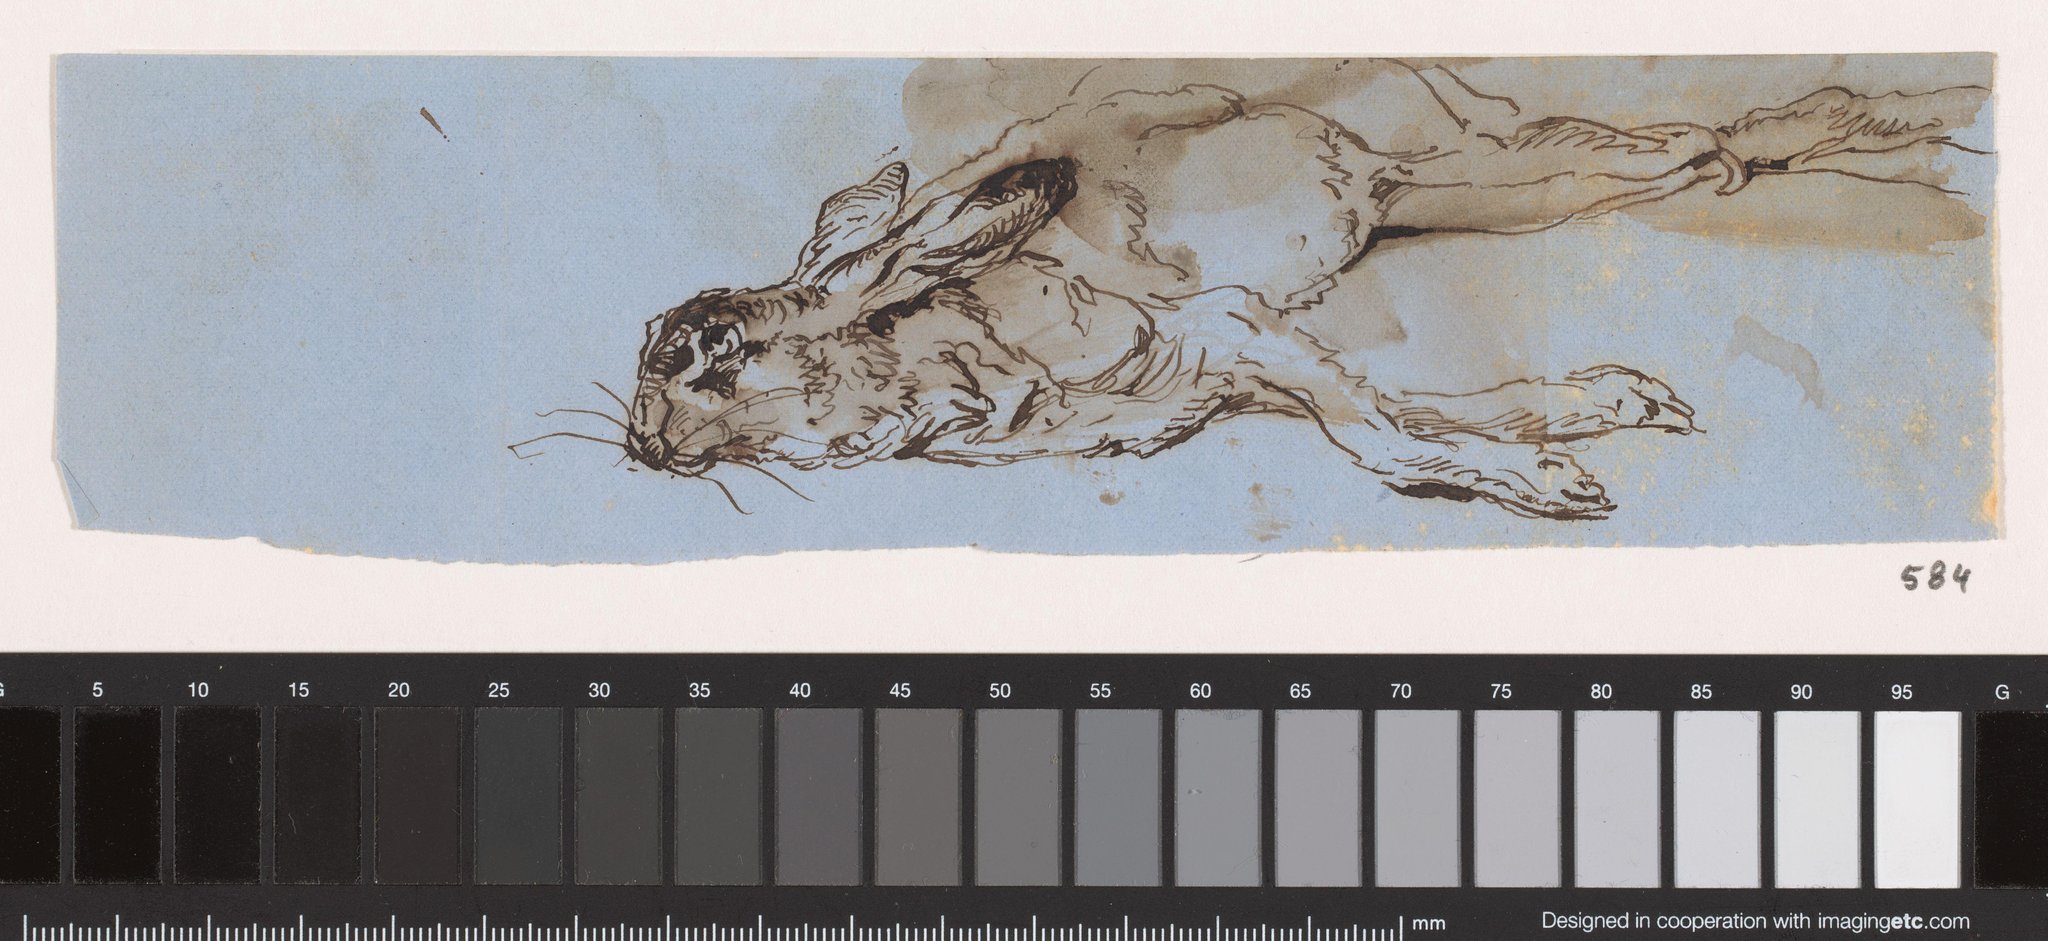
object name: drawing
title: Dode haas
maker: johannes tavenraat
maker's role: draughtsman, painter, print maker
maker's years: 1809-1881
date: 1840-1880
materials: ink, paper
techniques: brush, pen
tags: rodents (with name) (+ dying animal; death of animal; dead animal)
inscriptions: collector's mark: Lugt 2228